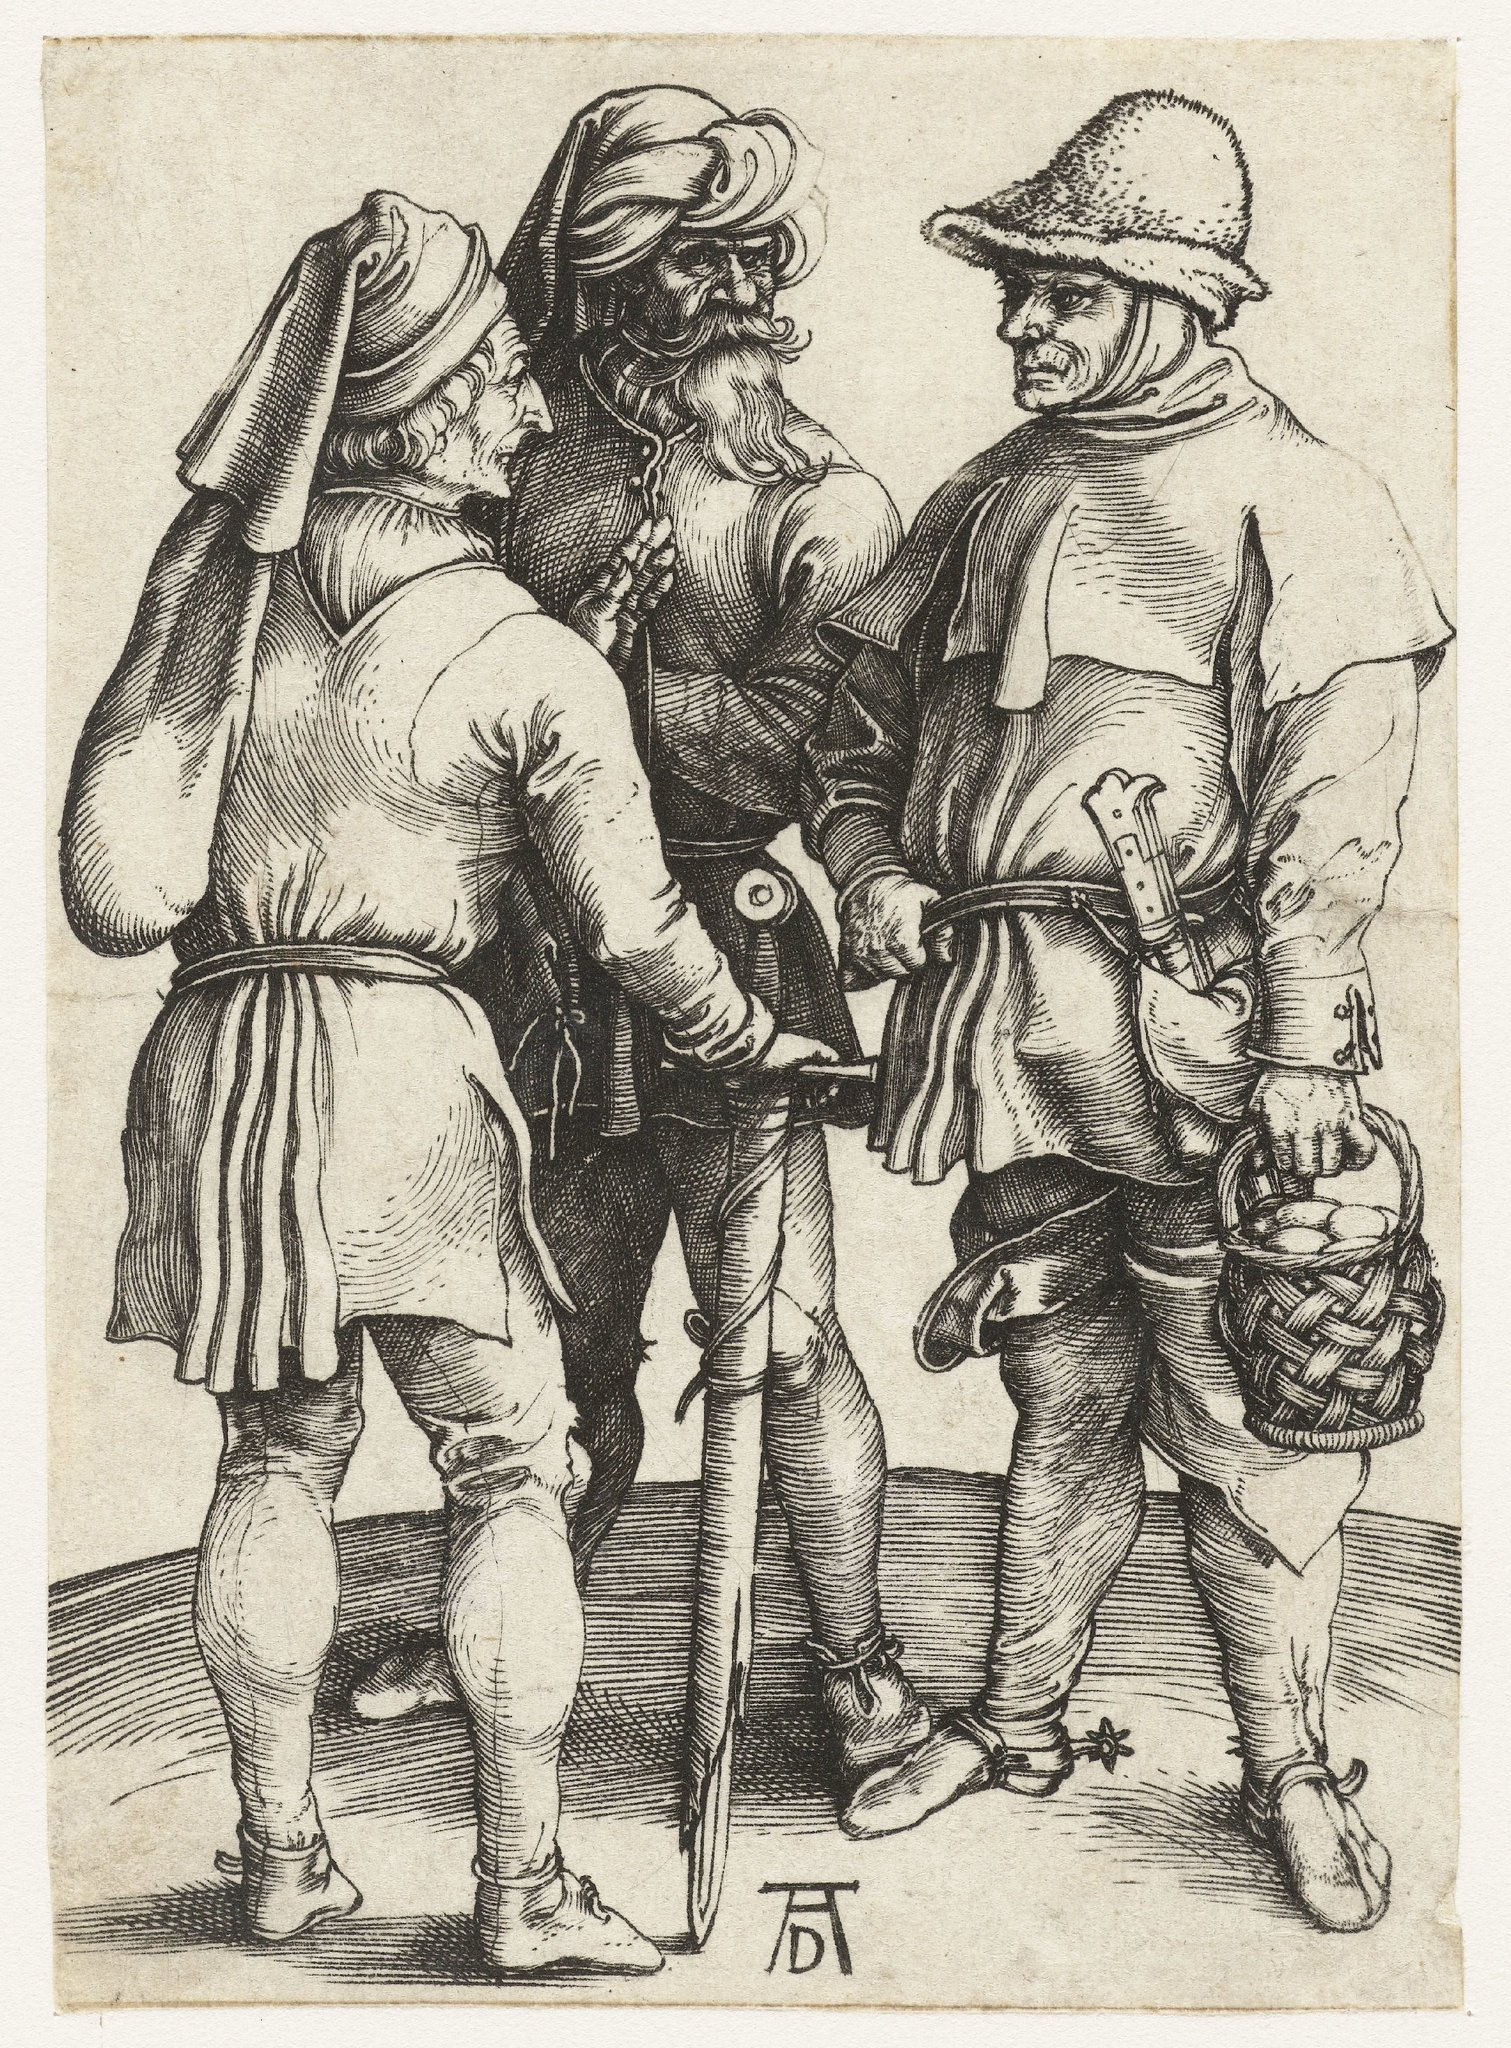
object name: print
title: Drie boeren in gesprek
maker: albrecht dürer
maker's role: draughtsman, painter, print maker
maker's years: 1471-1528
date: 1495-1499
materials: paper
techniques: engraving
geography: nuremberg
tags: farmers, conversation, dialogue; conversation piece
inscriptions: collector's mark: Lugt 2228a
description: Drie mannen staan met elkaar te praten. Een van hen houdt een zwaard vast, een ander een mandje eieren, de derde heeft een opvallende baard en tulbandachtig hoofddeksel.